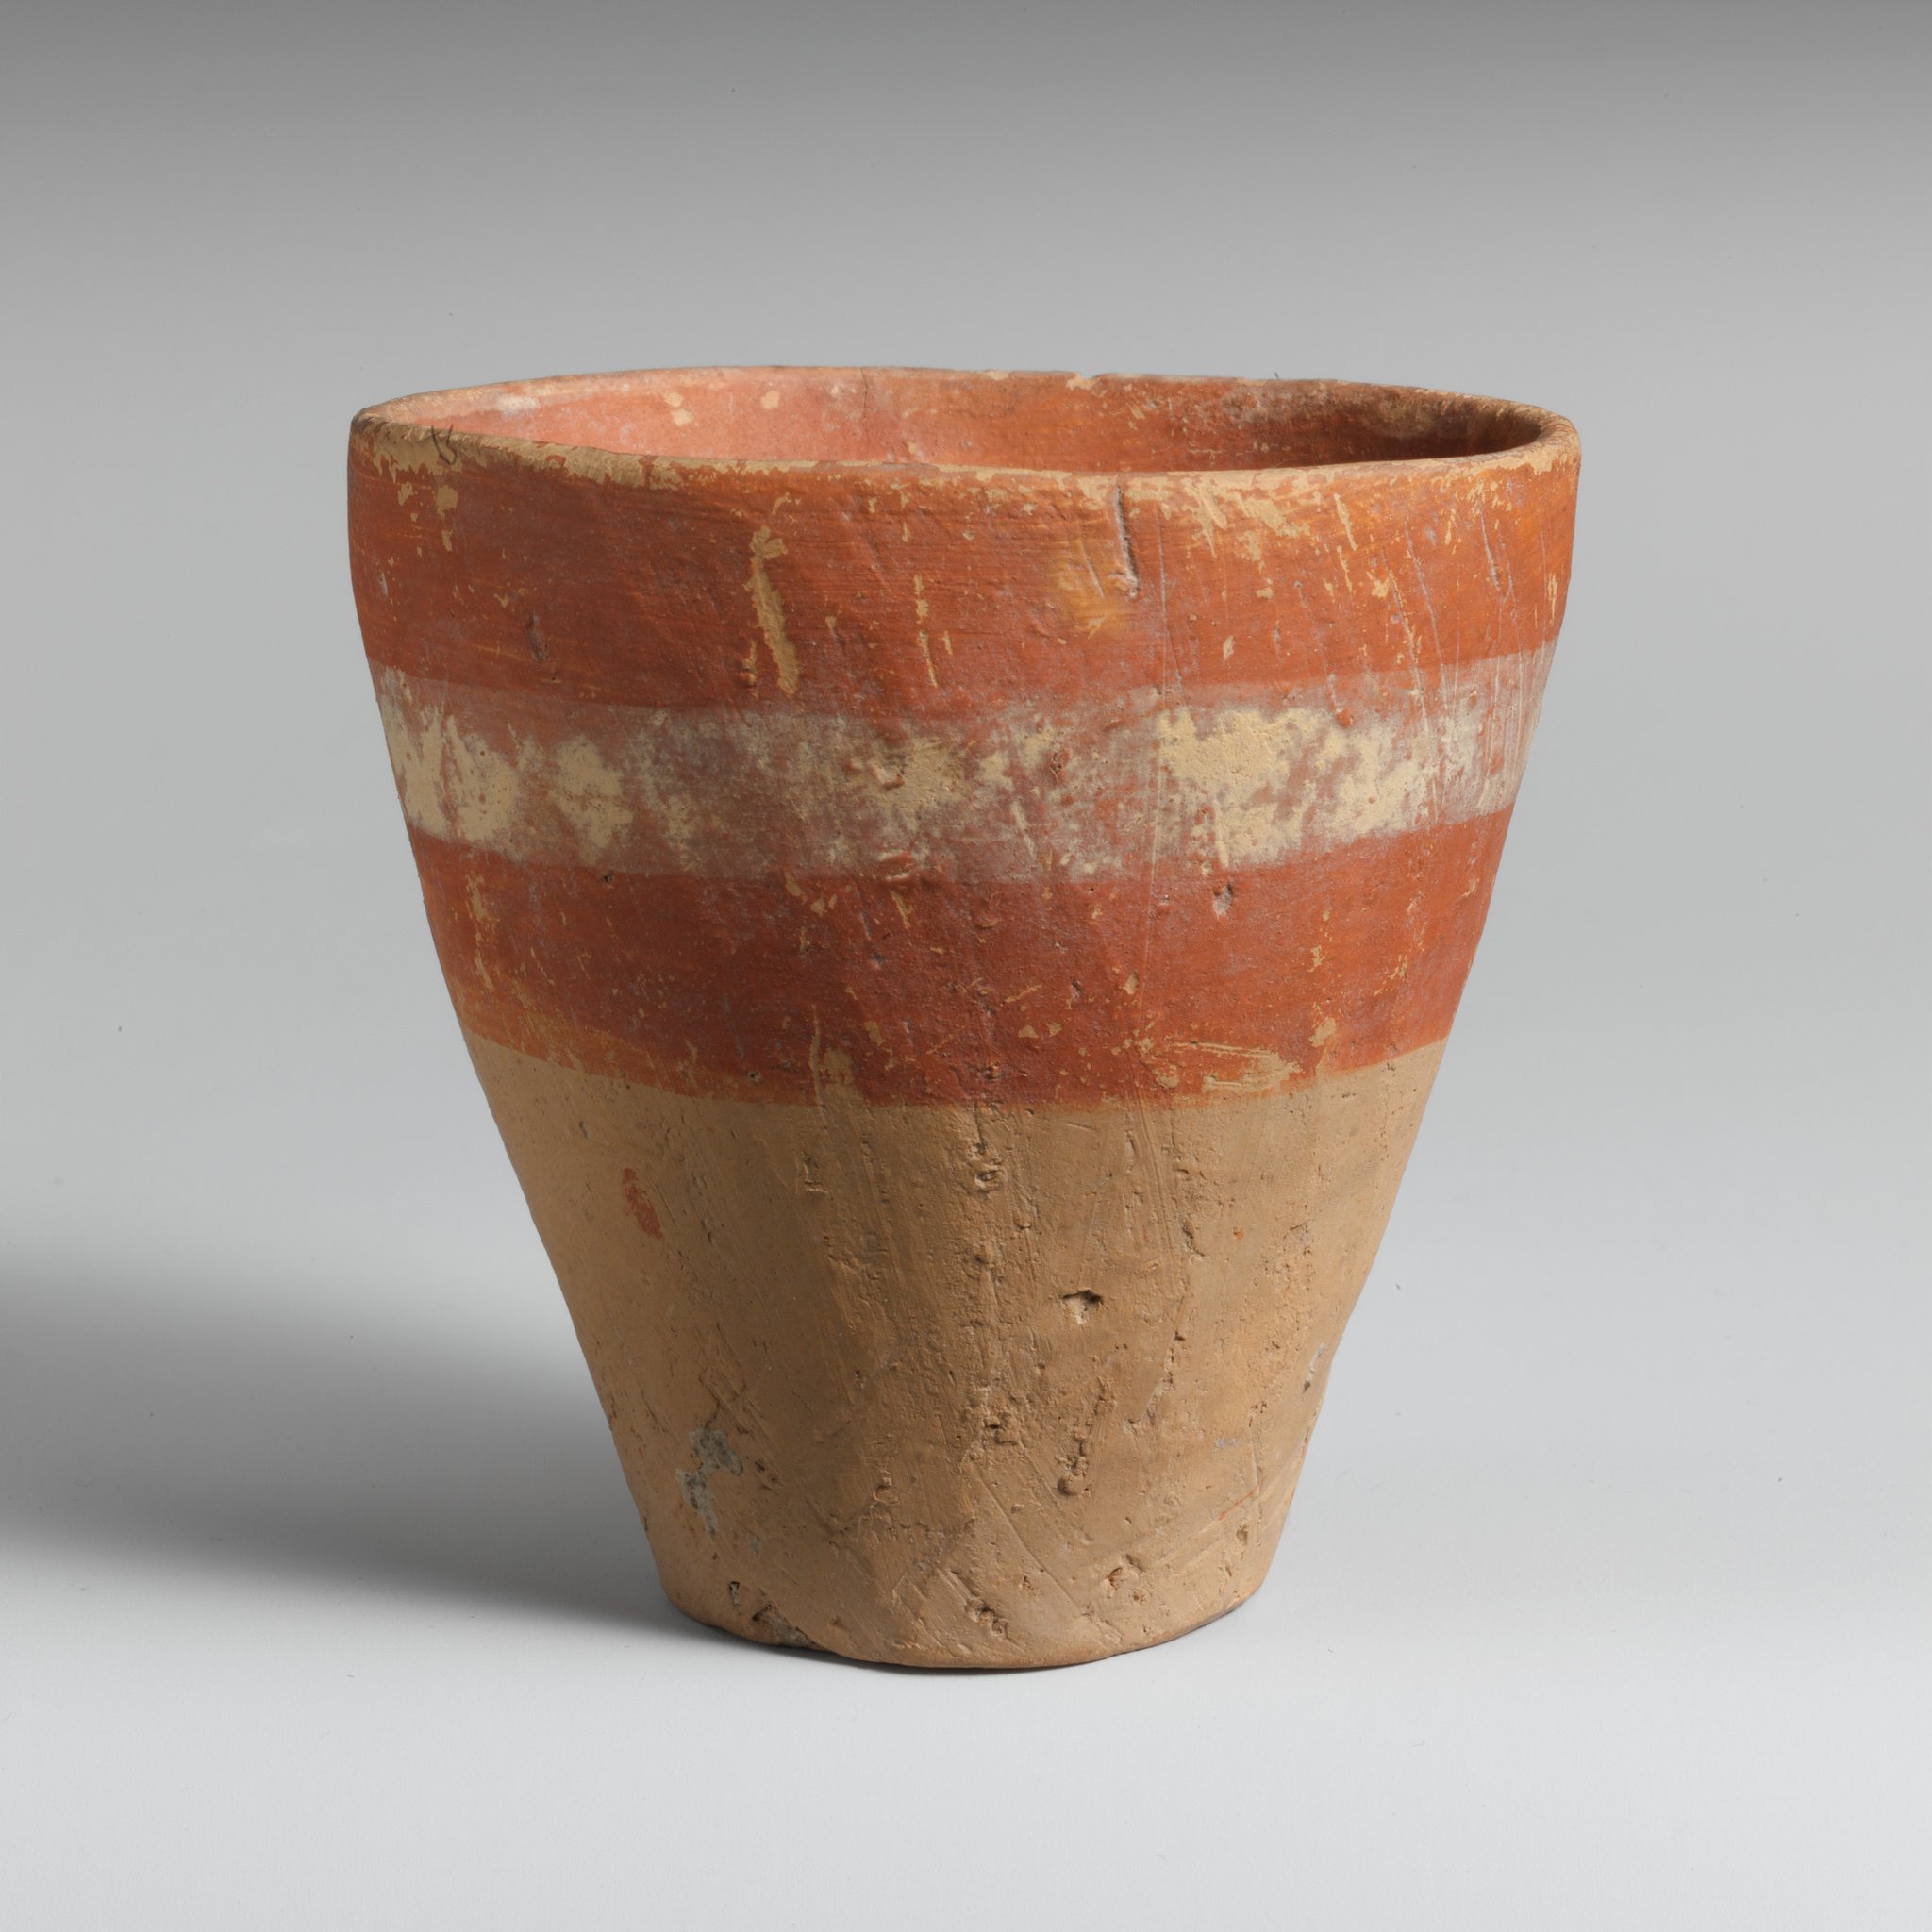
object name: beaker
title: Terracotta tumbler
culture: minoan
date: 2100-1950 BCE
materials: terracotta